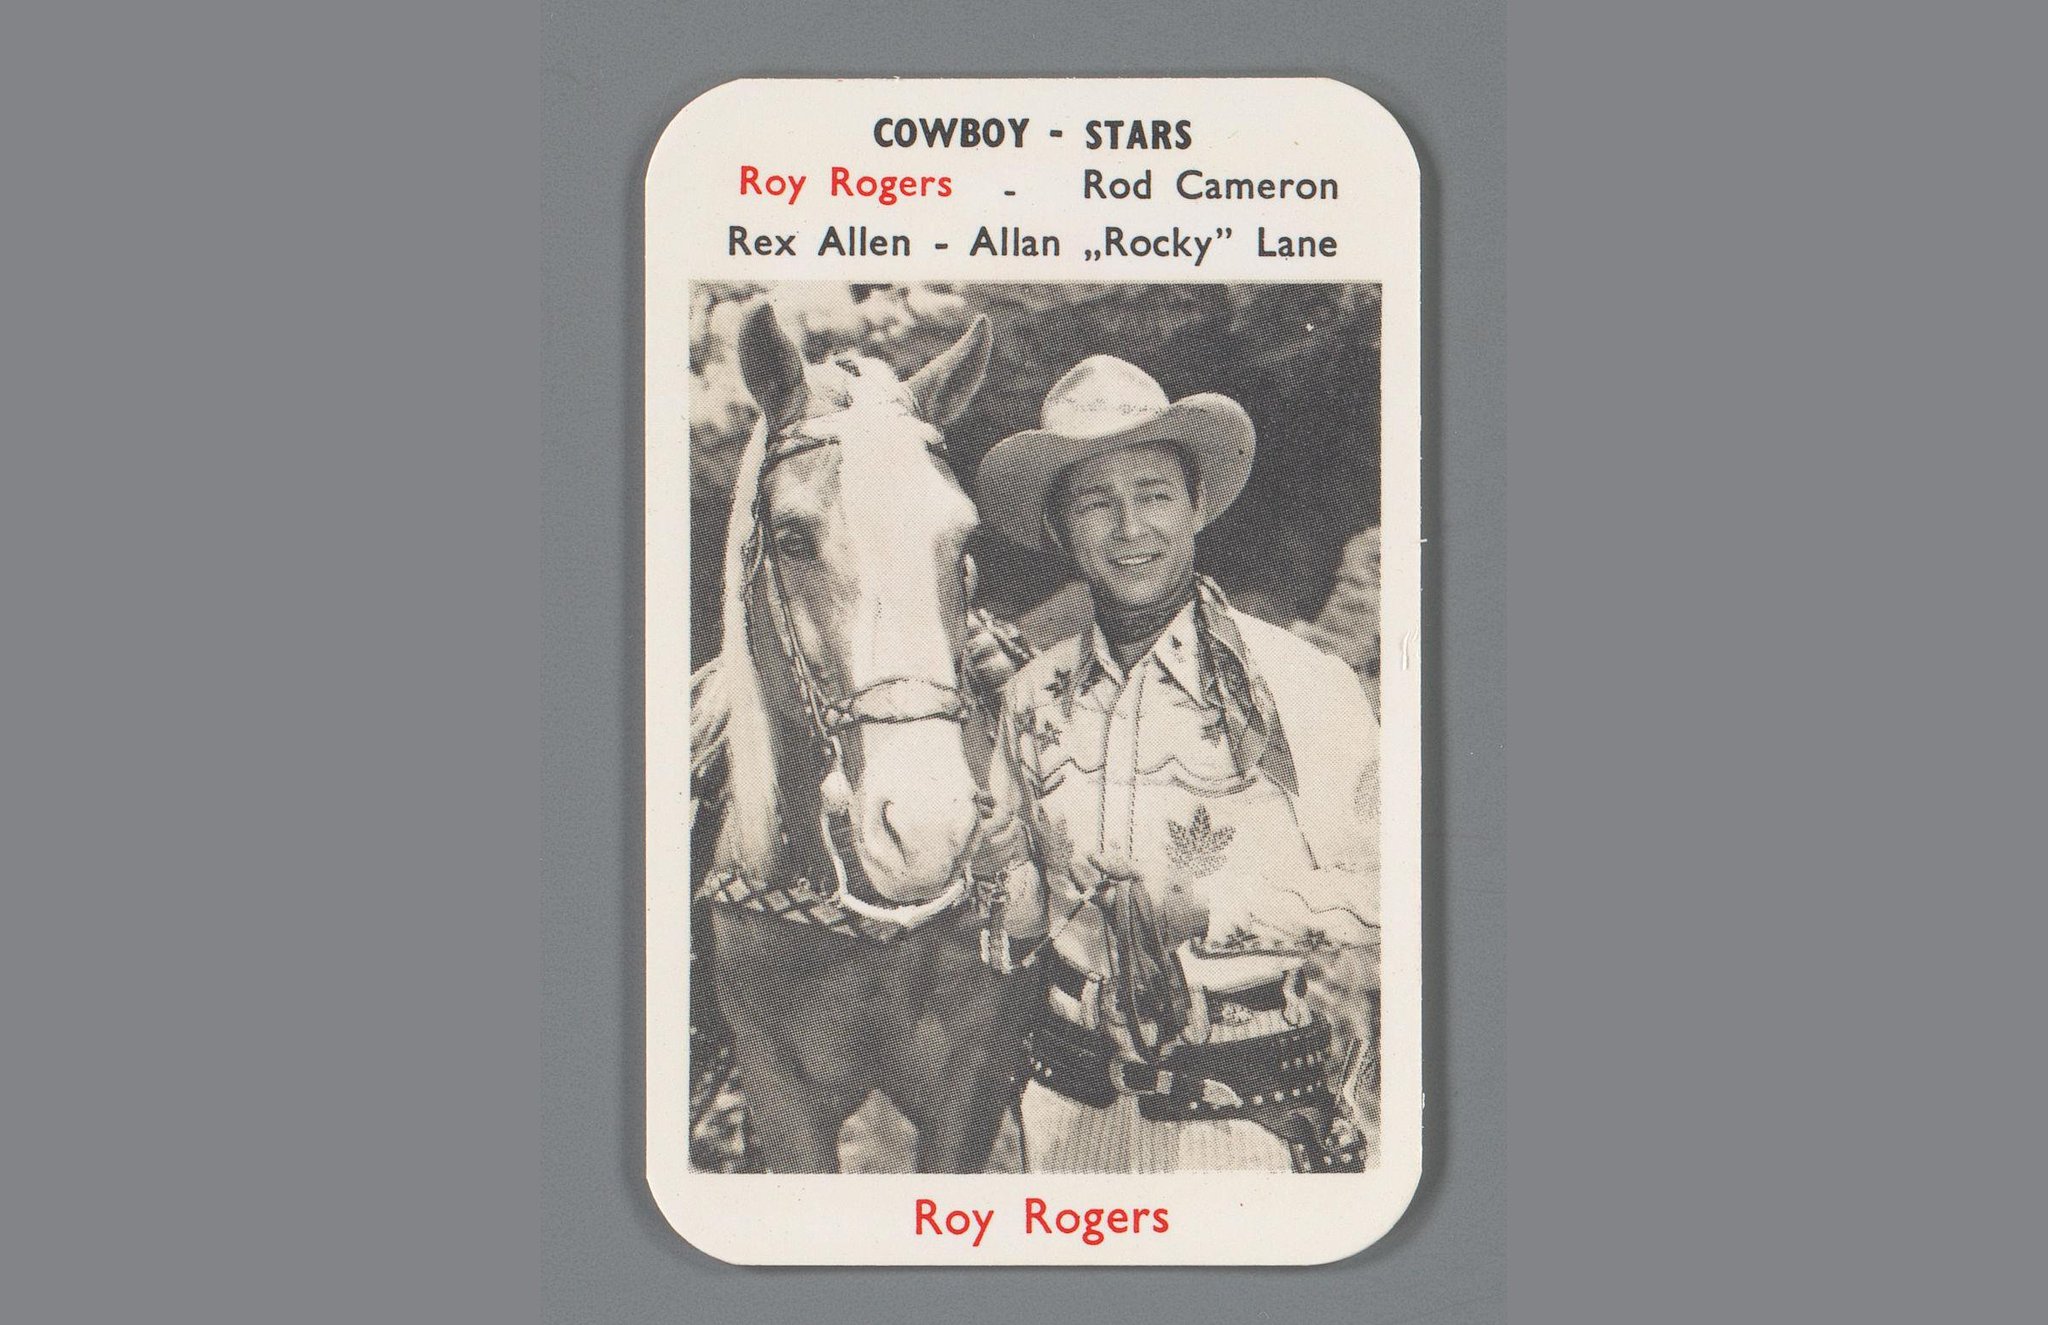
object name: photomechanical print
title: Portret van Roy Rogers; onderdeel van het kwartet Cowboy-Stars uit een kwartetspel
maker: Anonymous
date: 1960-1970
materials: paper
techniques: autotype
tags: musician, portrait of actor, actress